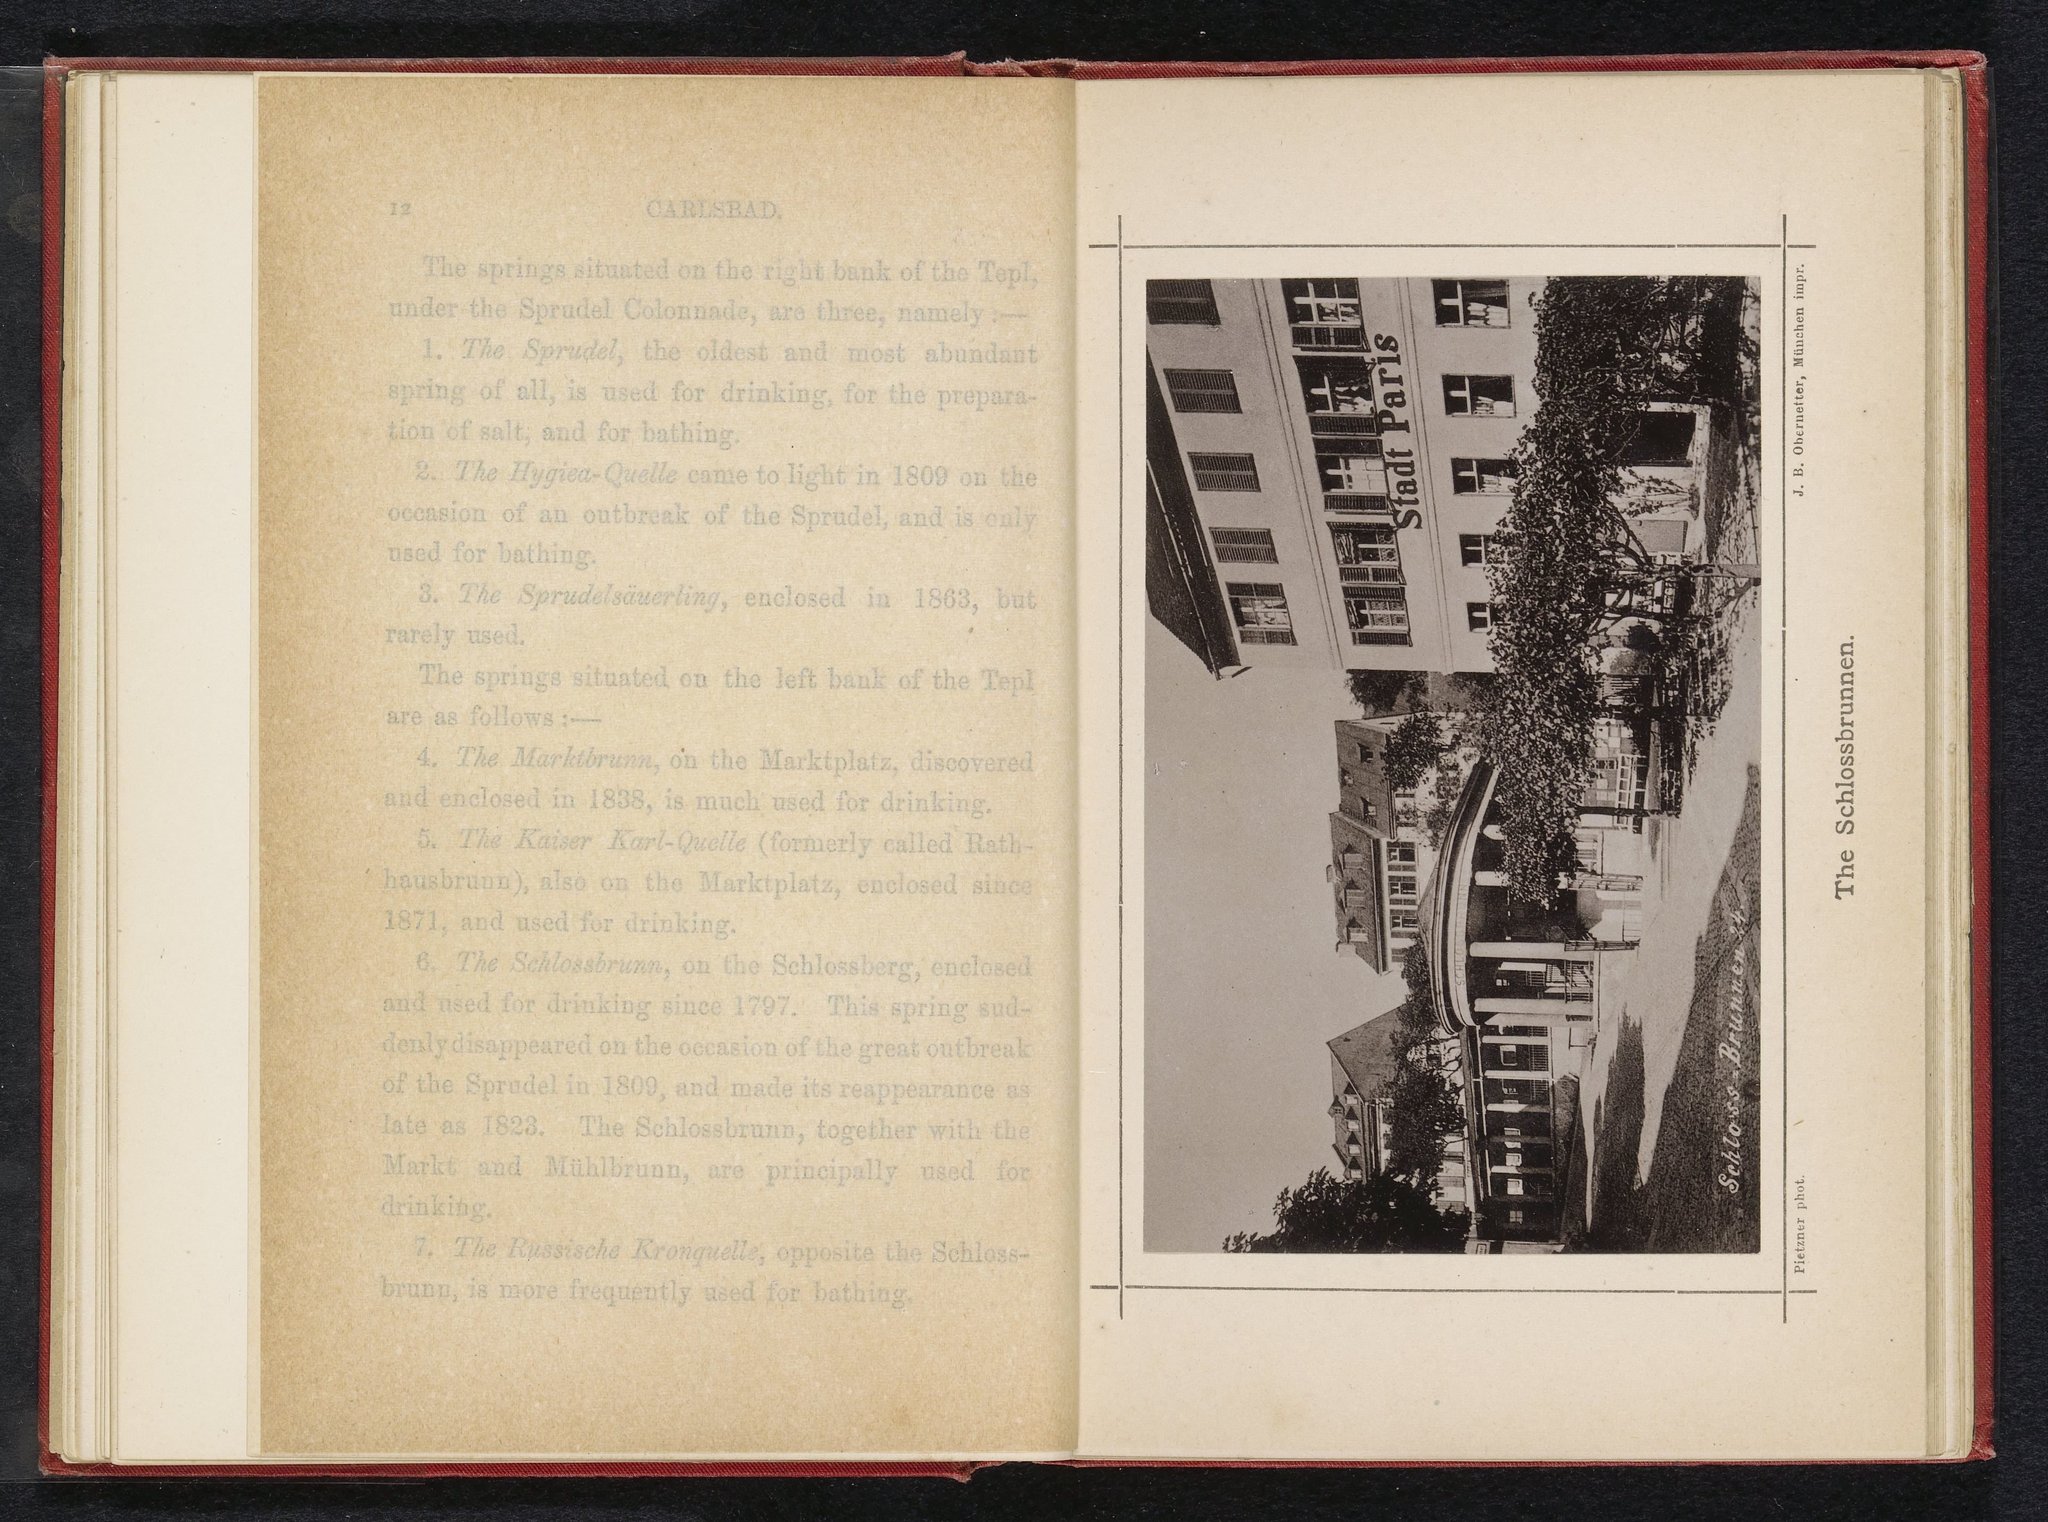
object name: page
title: The Schlossbrunnen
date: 1881-1891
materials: paper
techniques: photograph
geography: munich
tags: advertising, hot spring, geyser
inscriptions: inscription: ‘Schloss Brunnen 24.’